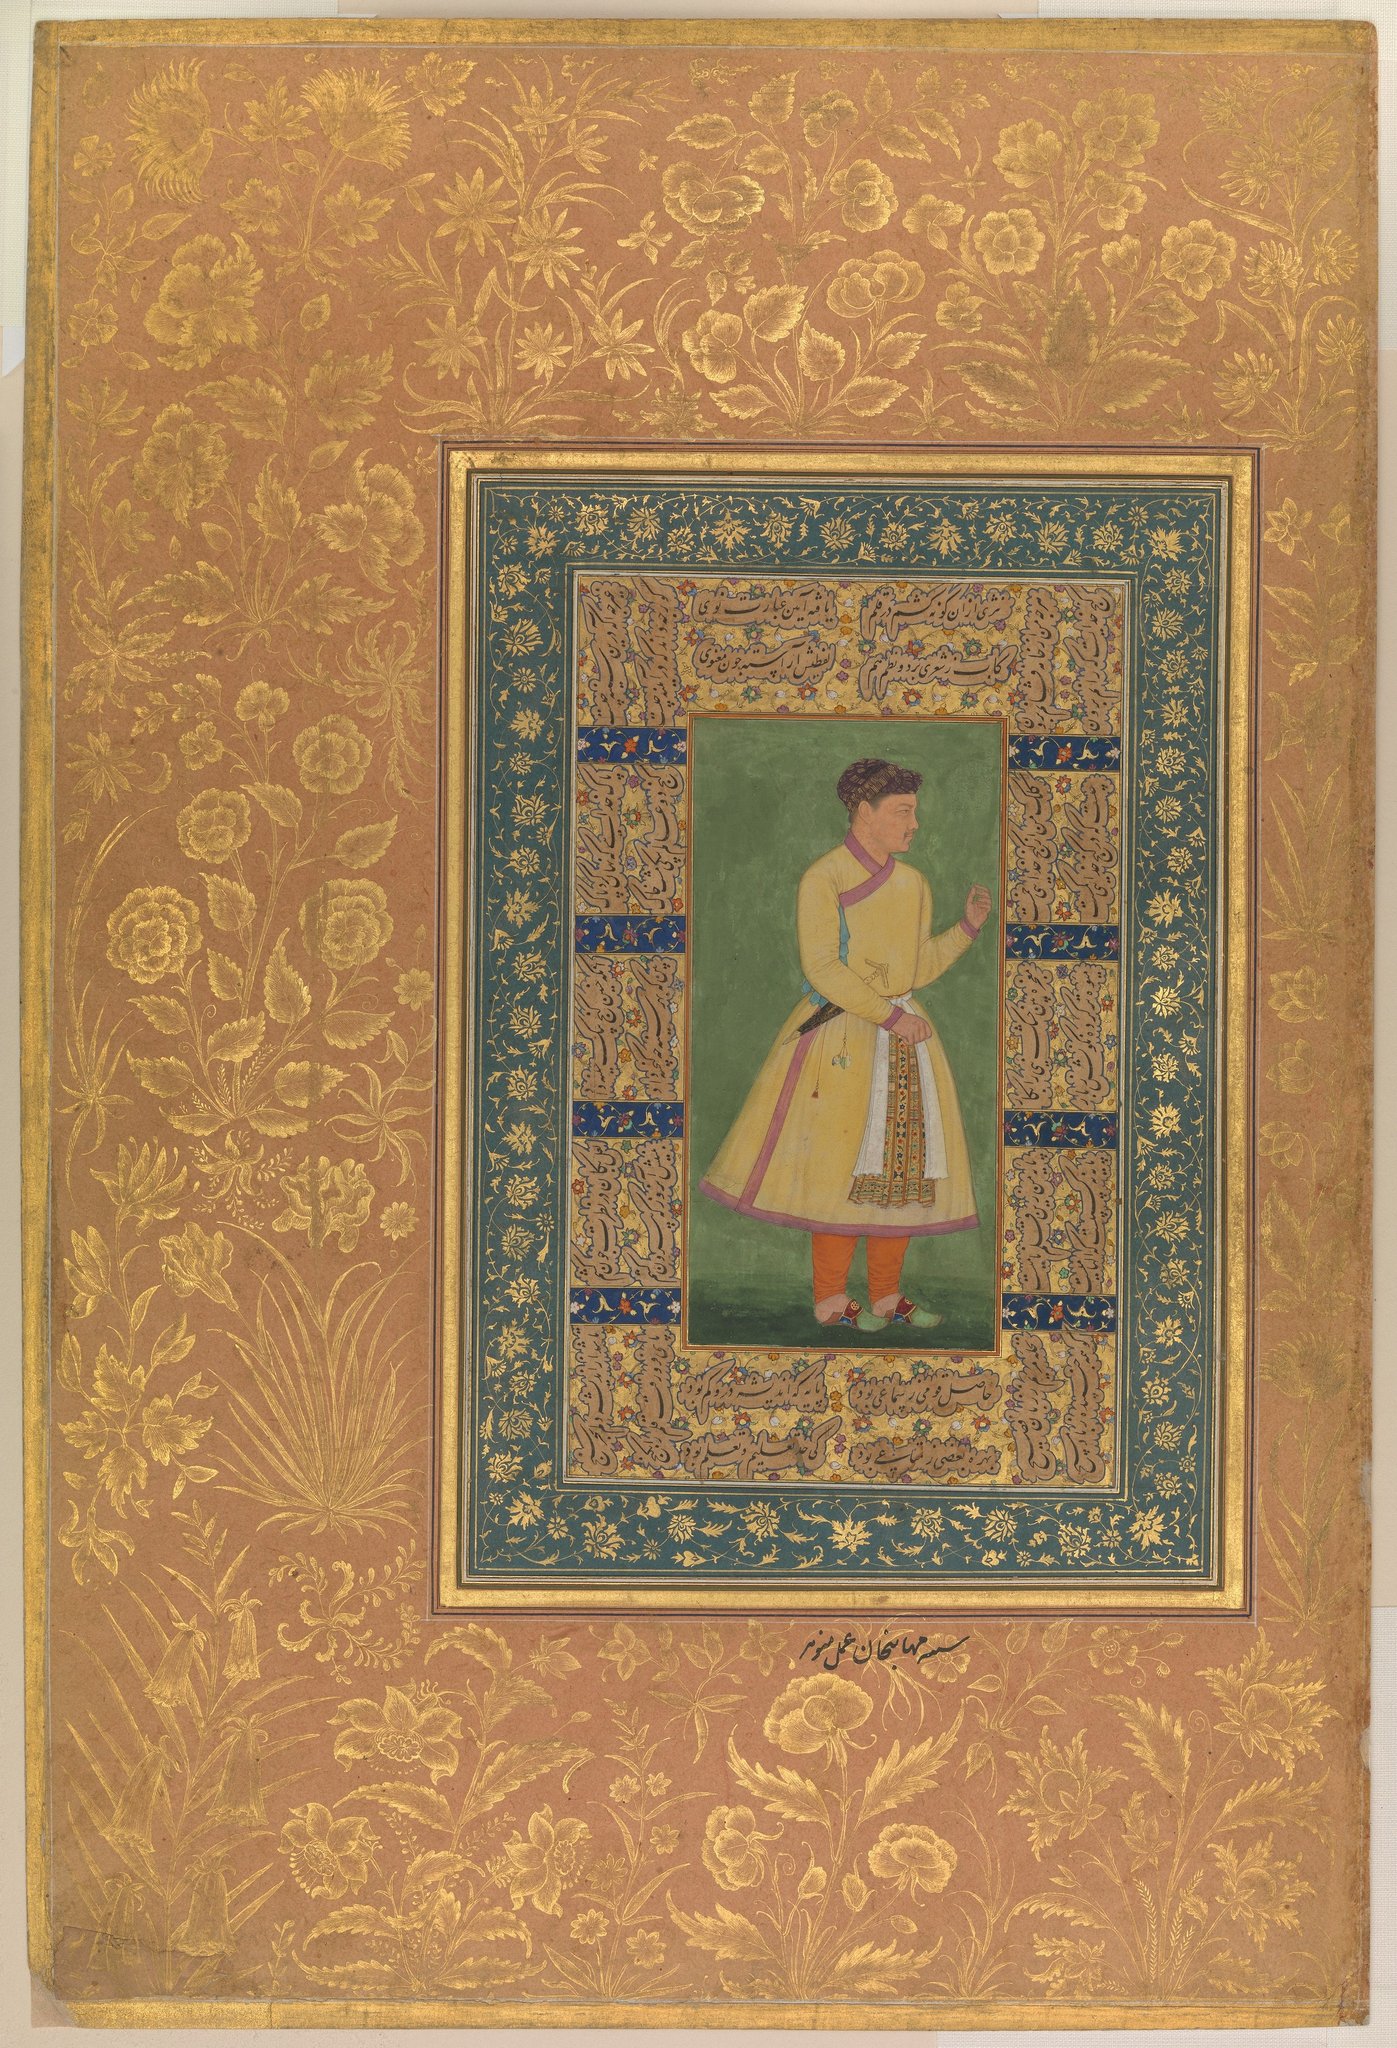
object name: album leaf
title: "Portrait of Zamana Beg, Mahabat Khan", Folio from the Shah Jahan Album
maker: manohar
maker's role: artist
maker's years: 1577-1624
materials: gold, ink, paper, watercolor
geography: india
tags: men,profiles,generals